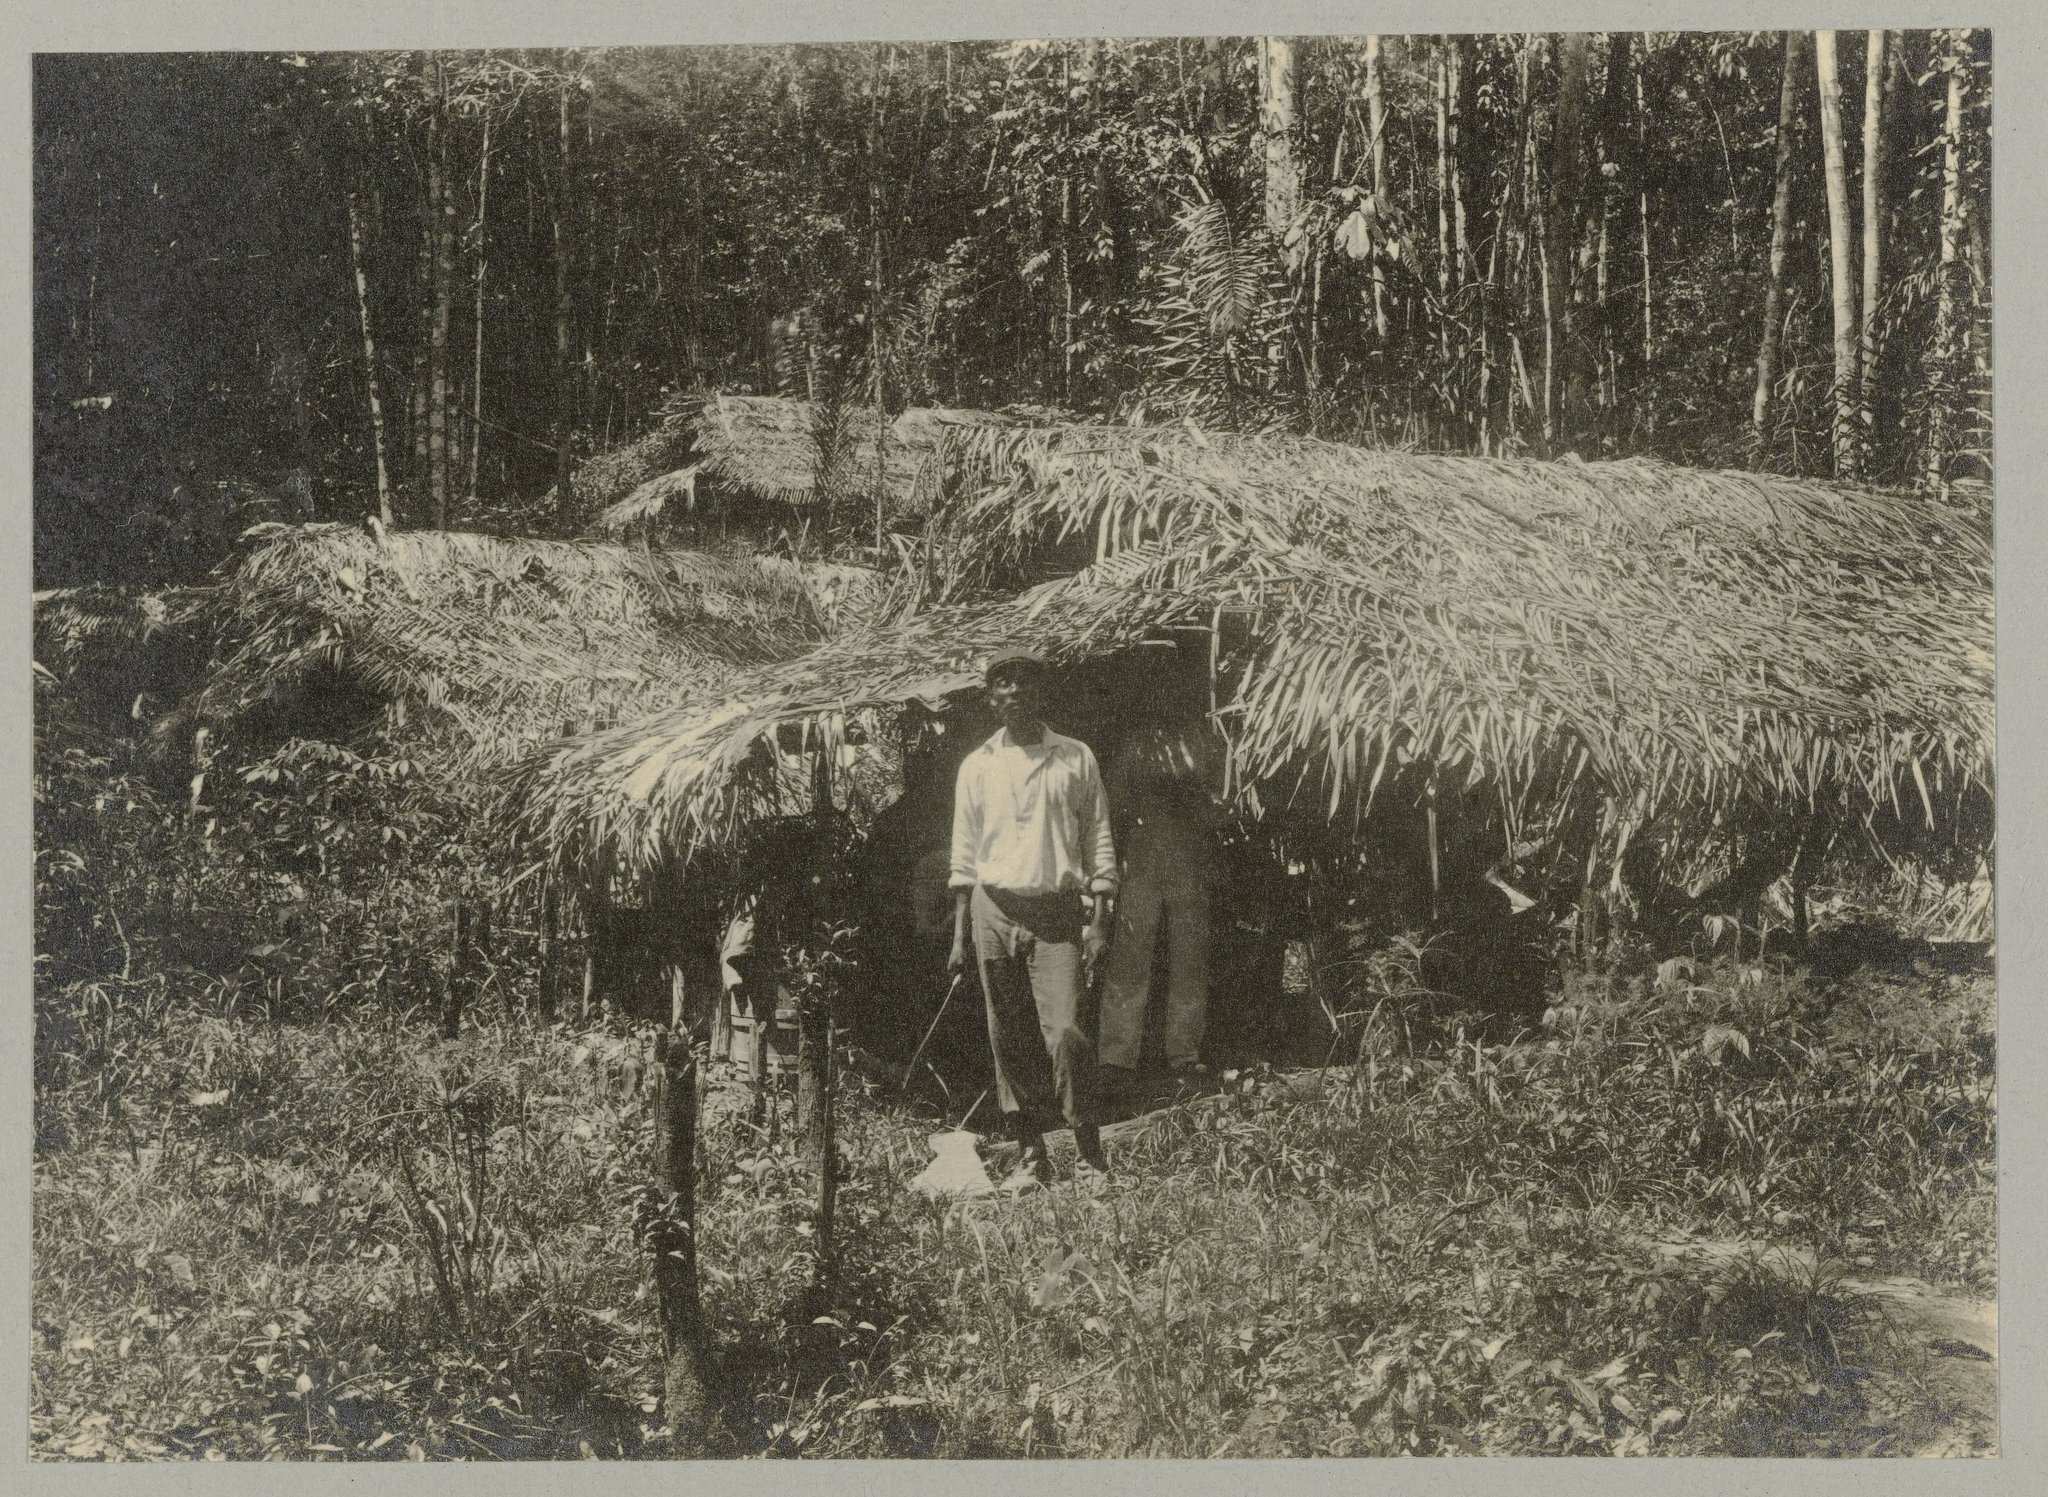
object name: photograph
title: Gouddelvers op placer de Jong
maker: hendrik doijer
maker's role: engineer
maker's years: 1863-1925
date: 1903-1910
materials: photographic support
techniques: gelatin silver print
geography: suriname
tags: suriname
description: Enkele gouddelvers staande bij de ingang van een kamp op de placer (concessie voor goudwinning) van de gebroeders L. en F. de Jong in Oost-Suriname. Onderdeel van het fotoalbum Souvenir de Voyage (deel 5), over het leven van de familie Doijer in en rond de plantage Ma Retraite in Suriname in de jaren 1903-1910.